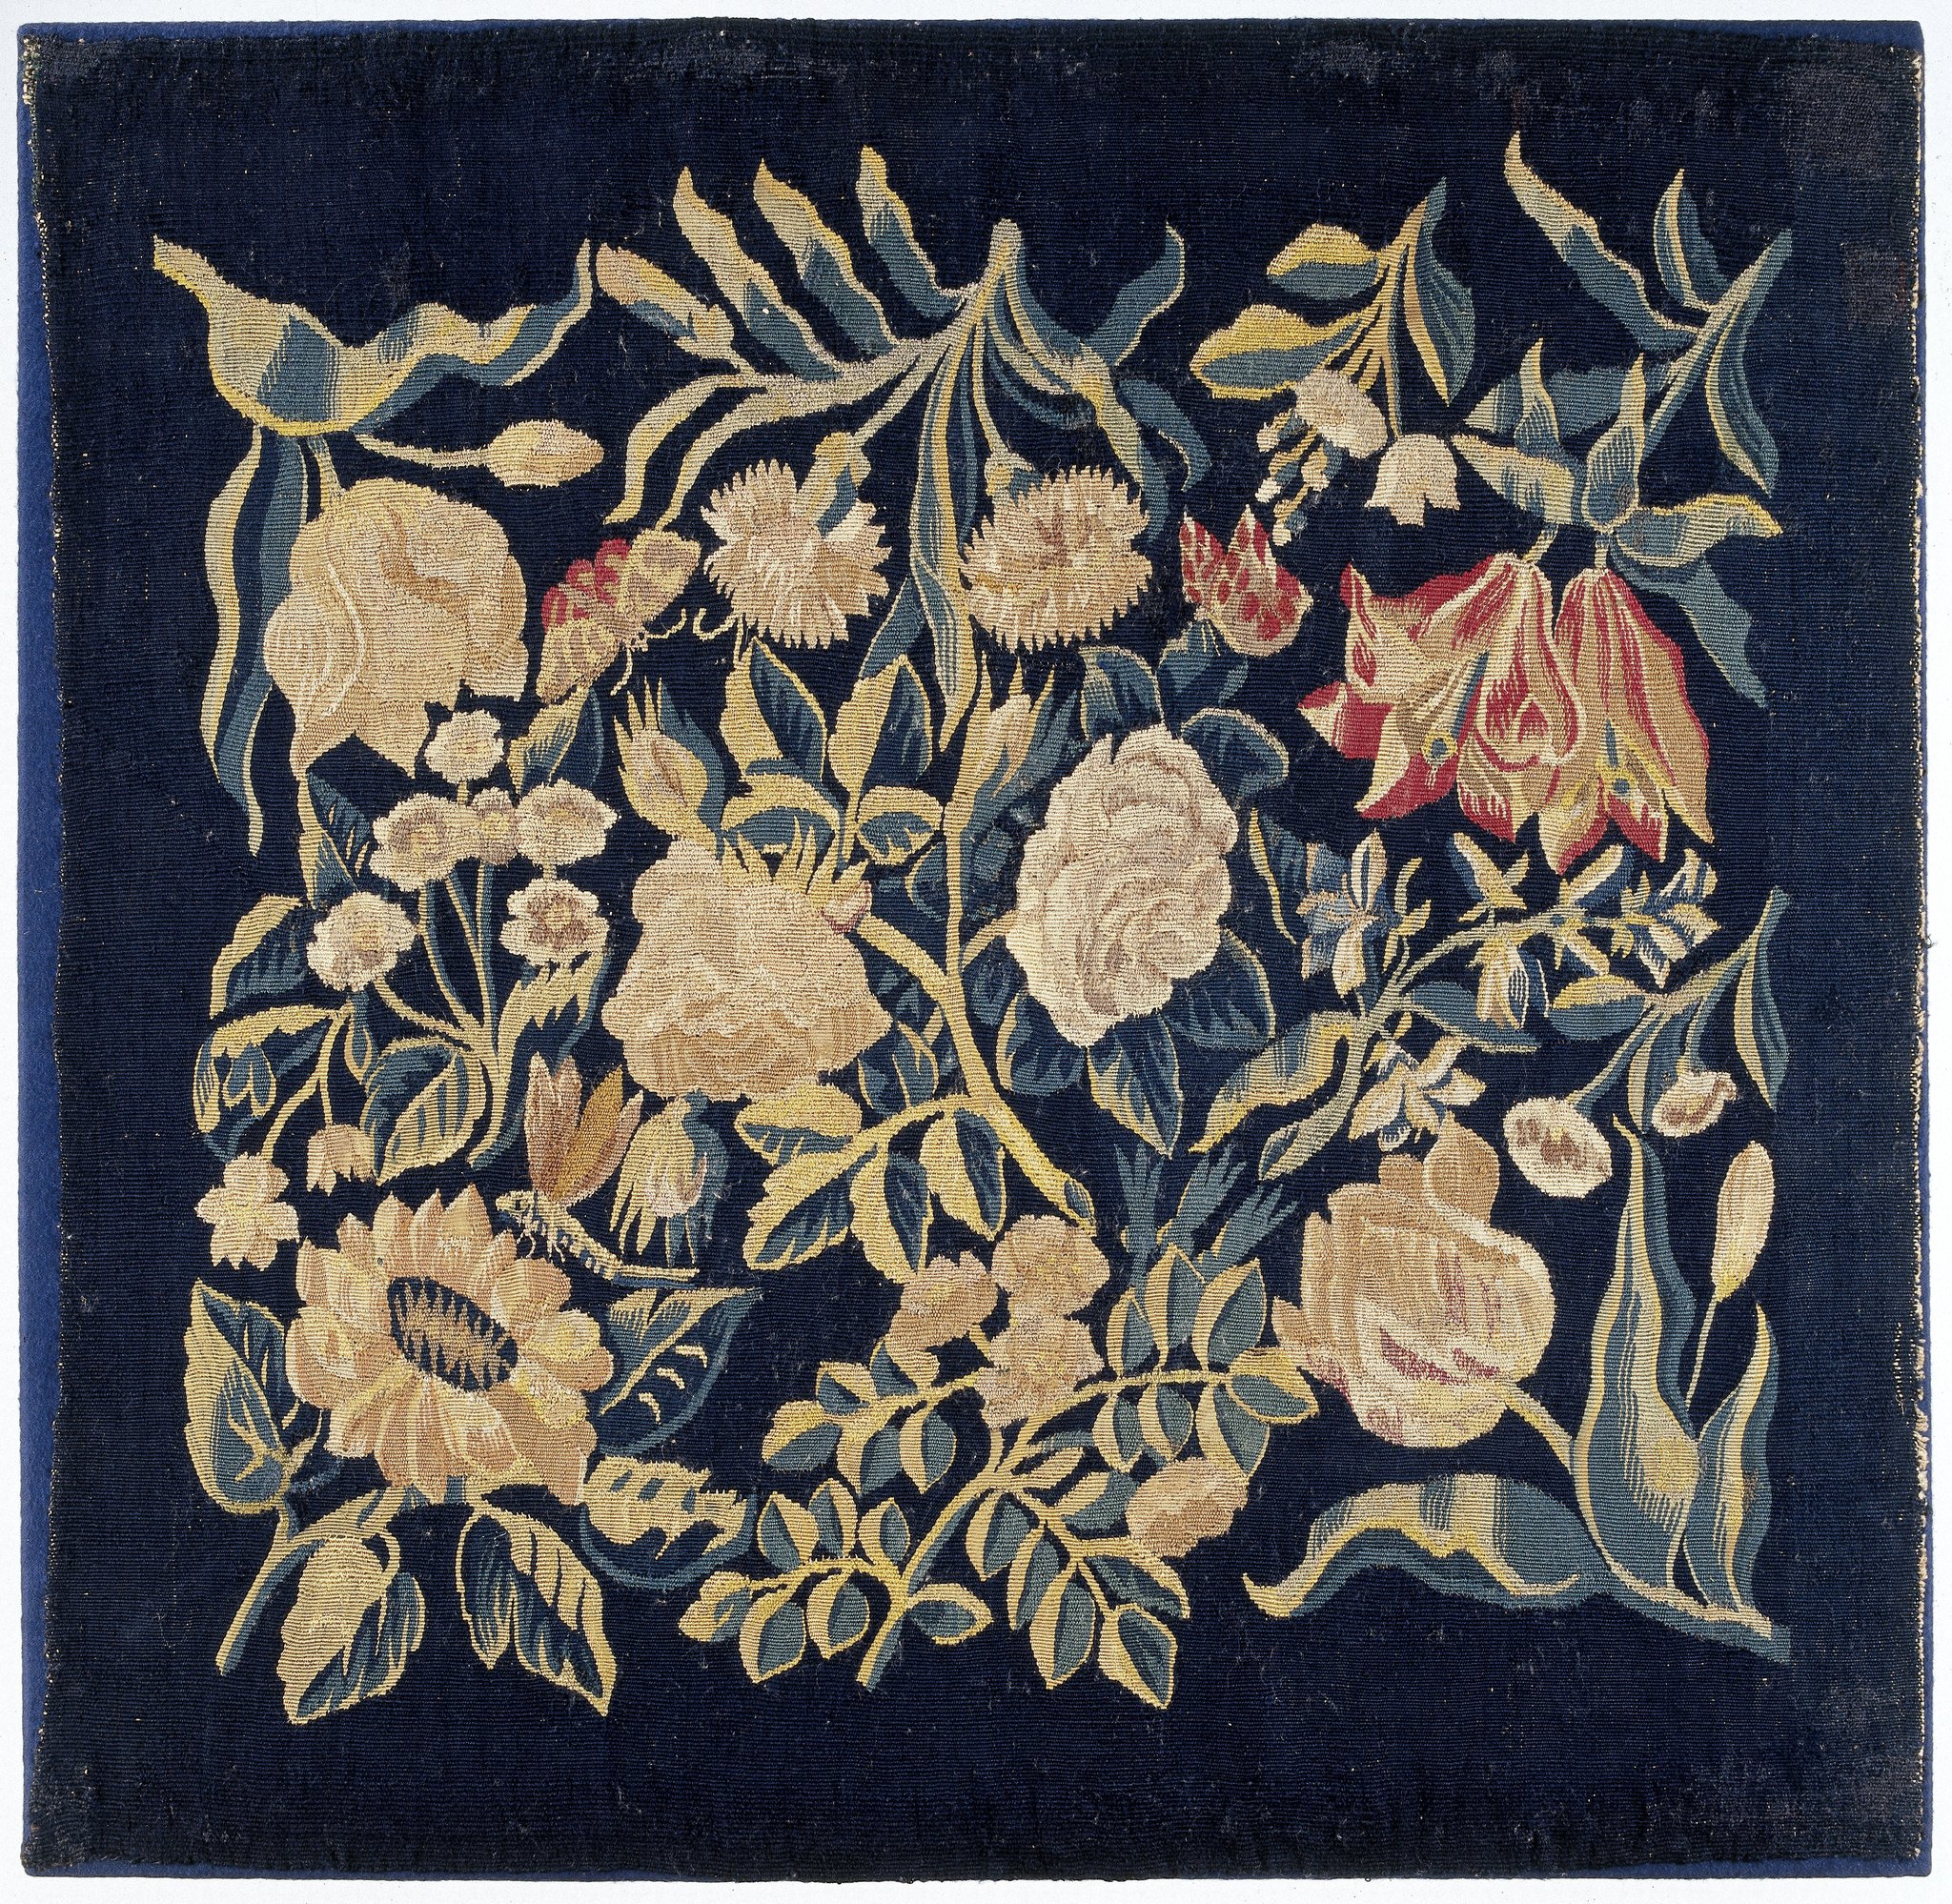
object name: stoelbekleding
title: Stoelbekleding met een bloemenpatroon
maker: Anonymous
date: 1650-1660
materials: silk, wool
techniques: tapestry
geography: northern netherlands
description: Stoelbekleding van tapisserie. Op een blauw-zwart fond is een vierkant met bladeren en bloemen. In het midden een roze en een witte maandroos; op de hoeken naar binnenwaarts gerichte rode lelies, twee roze-oranje tulpen, een zonnebloem (of klaproos?) in oranje. Op het midden der zijden in kleiner formaat een anjer, duinroos en ridderspoor. Tussen de bloemen een libel en twee vlinders